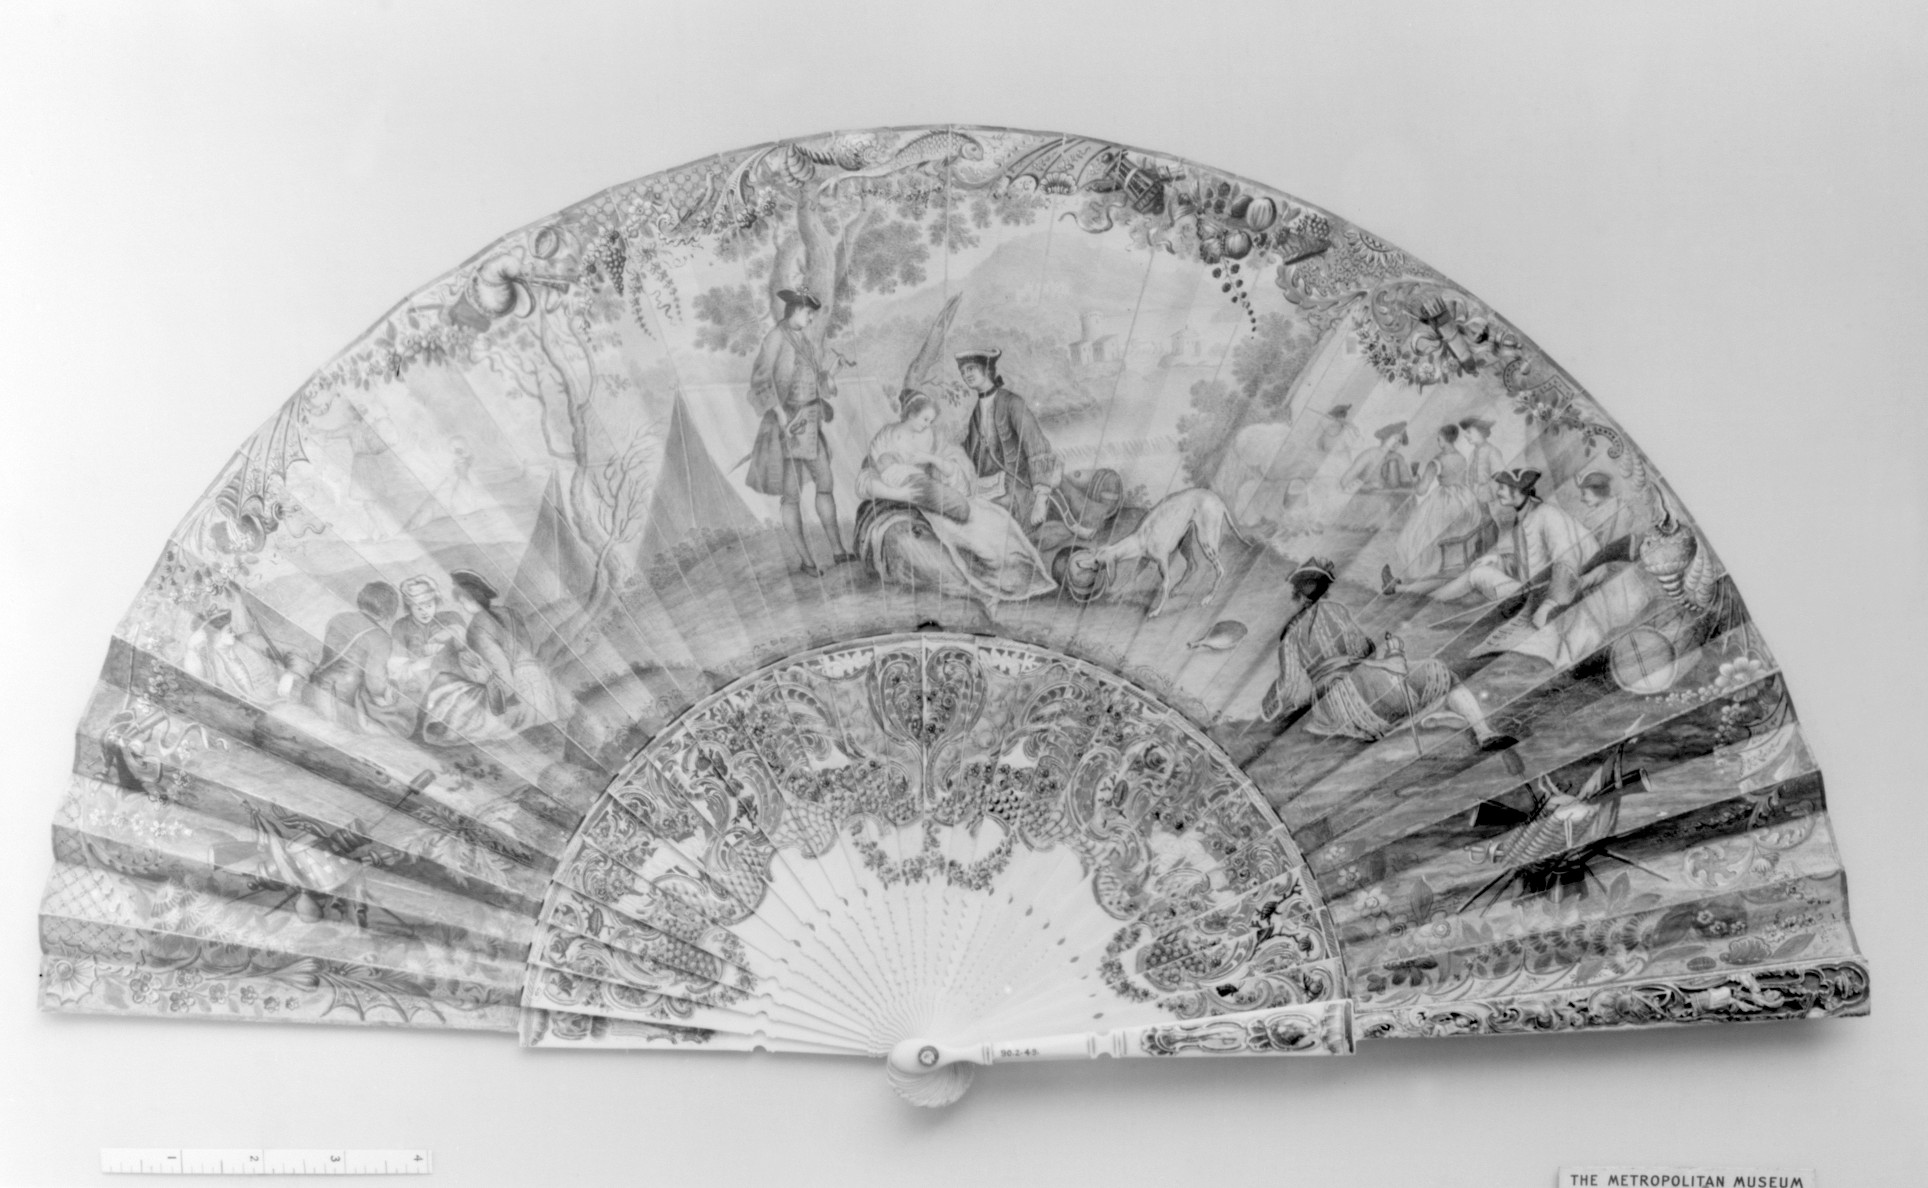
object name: fan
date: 1701-1750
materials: ivory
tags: men,women,dogs